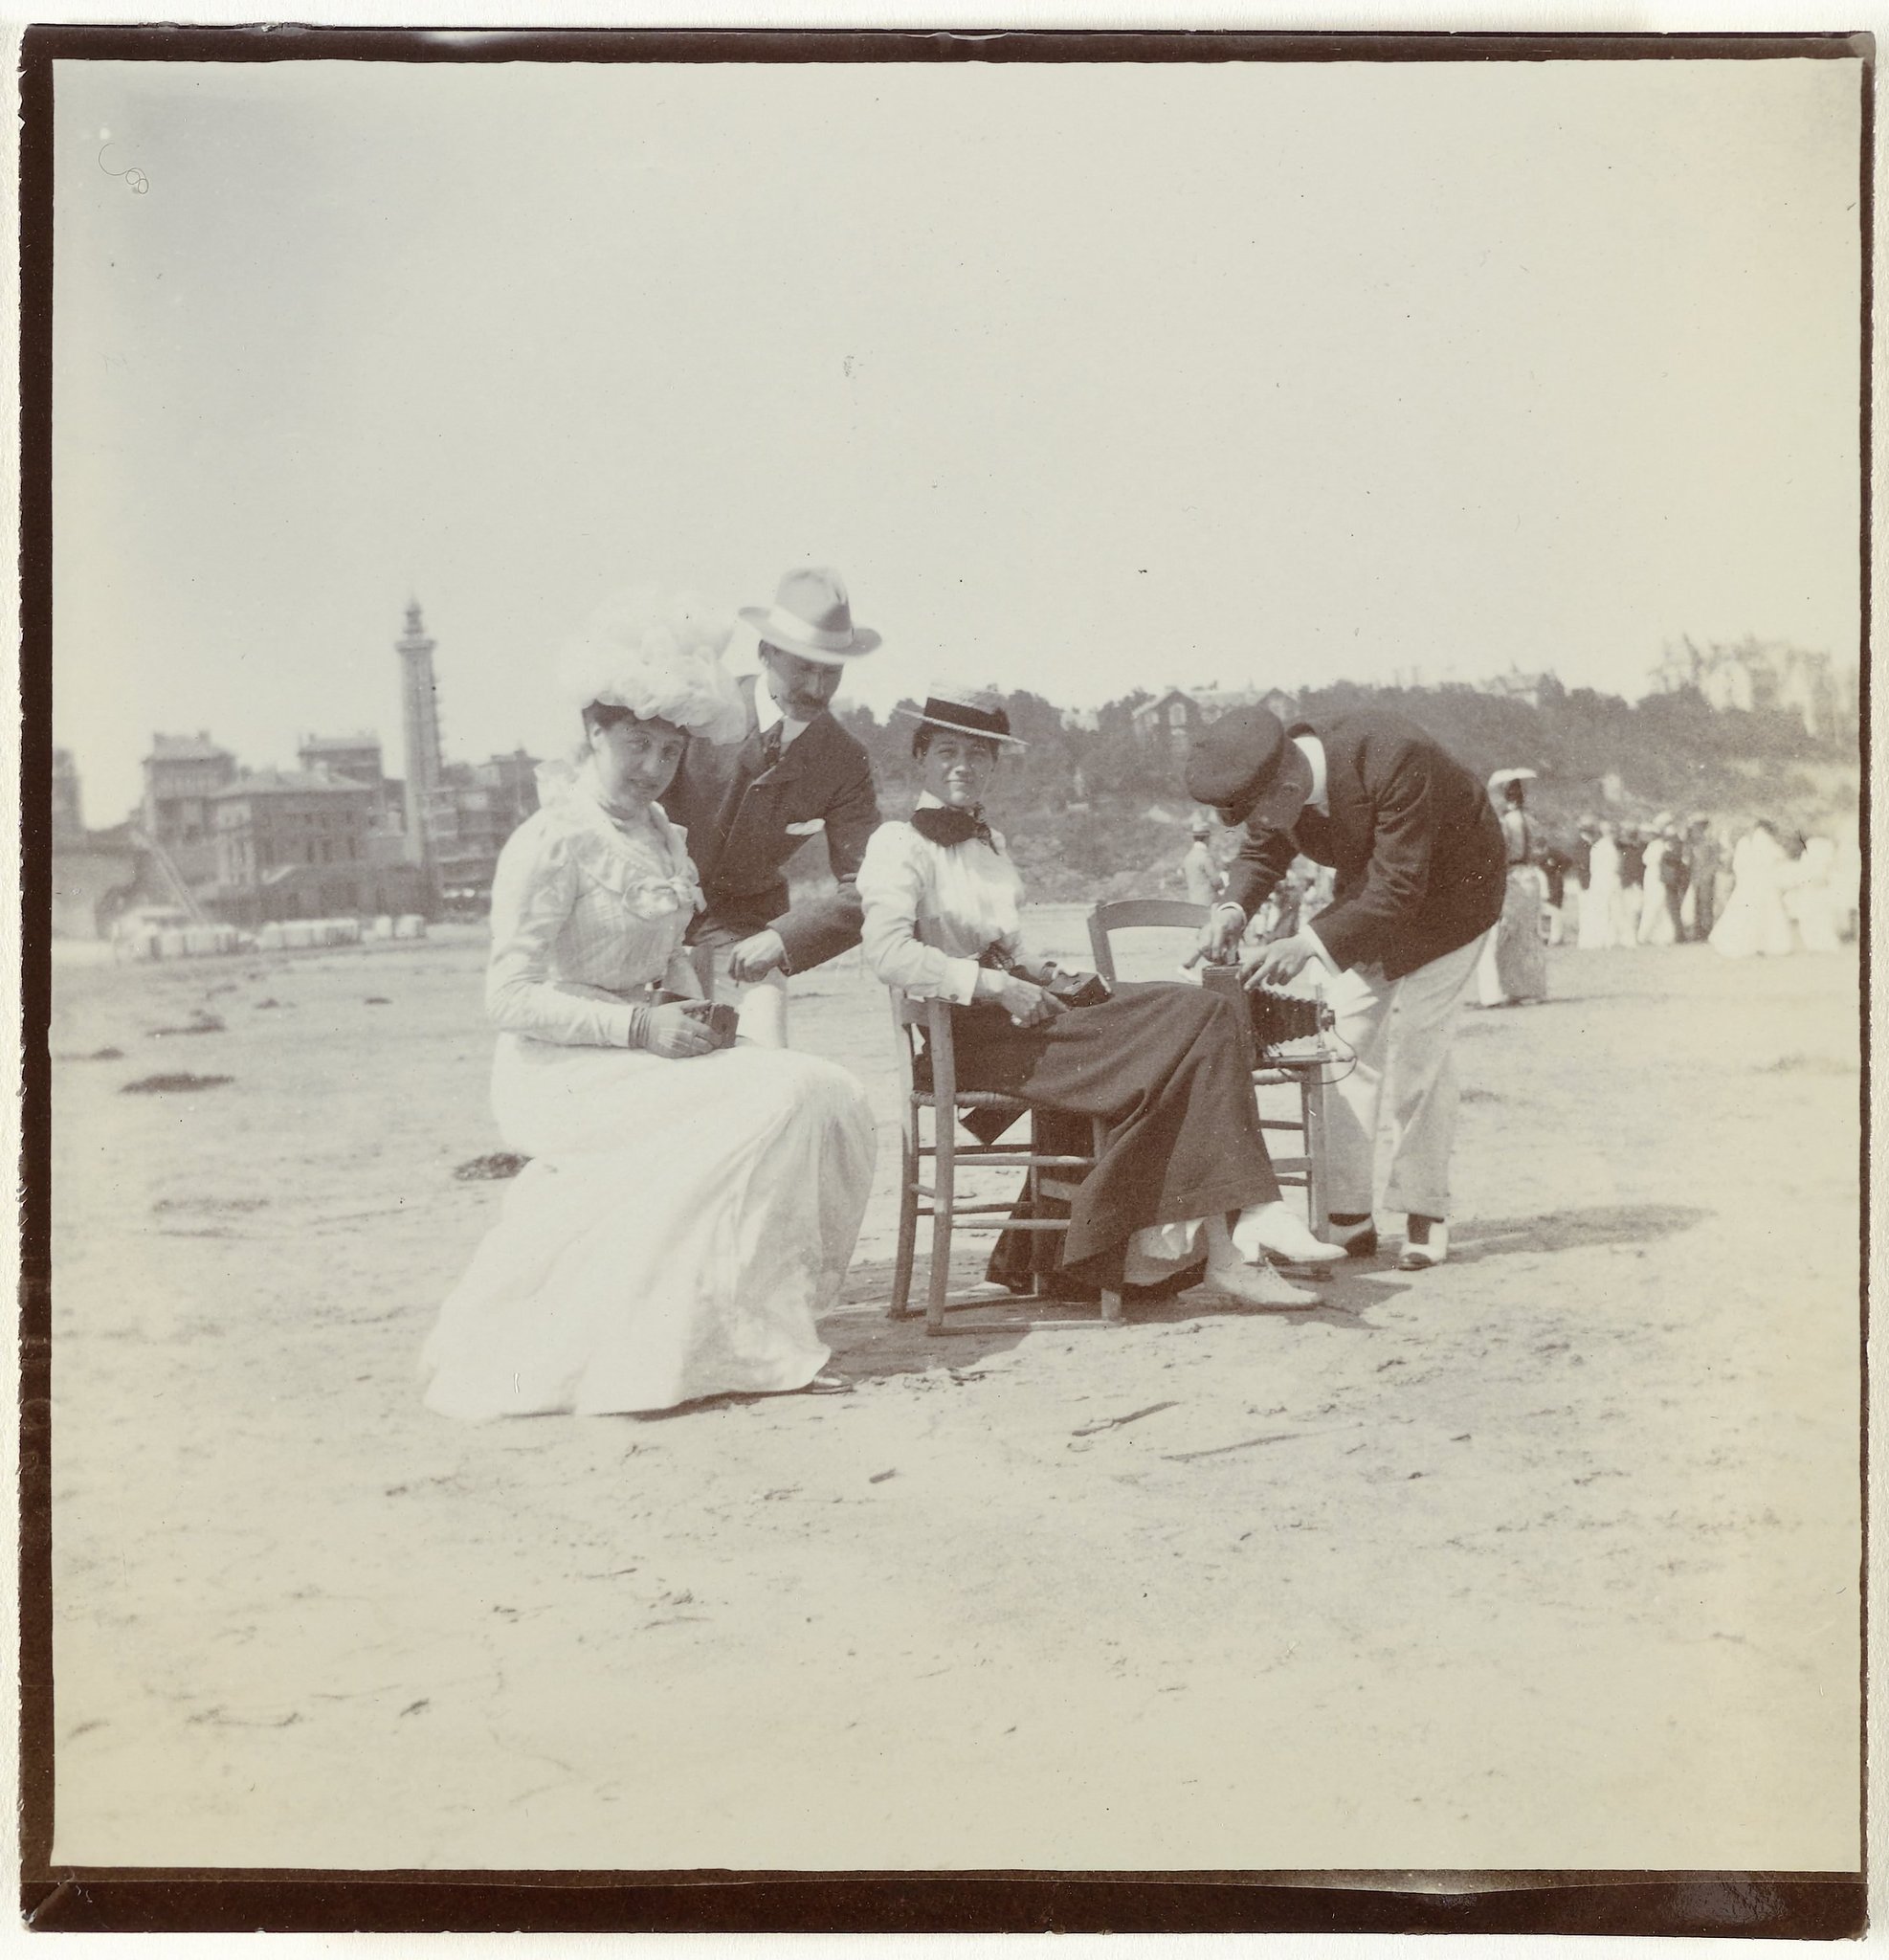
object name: photograph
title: Enthoven Girl with Friends on the Beach in Normandy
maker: Anonymous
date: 1900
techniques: photography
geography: normandy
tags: beach (as place of recreation)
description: Thanks to the handheld camera photography soon became the cheerful parlour game that we see in these Kodak photographs. Everyone on the beach is busy with their own camera and Enthoven’s Italian friends pose for and cavort with each other. One of the women holds a Pocket Kodak.